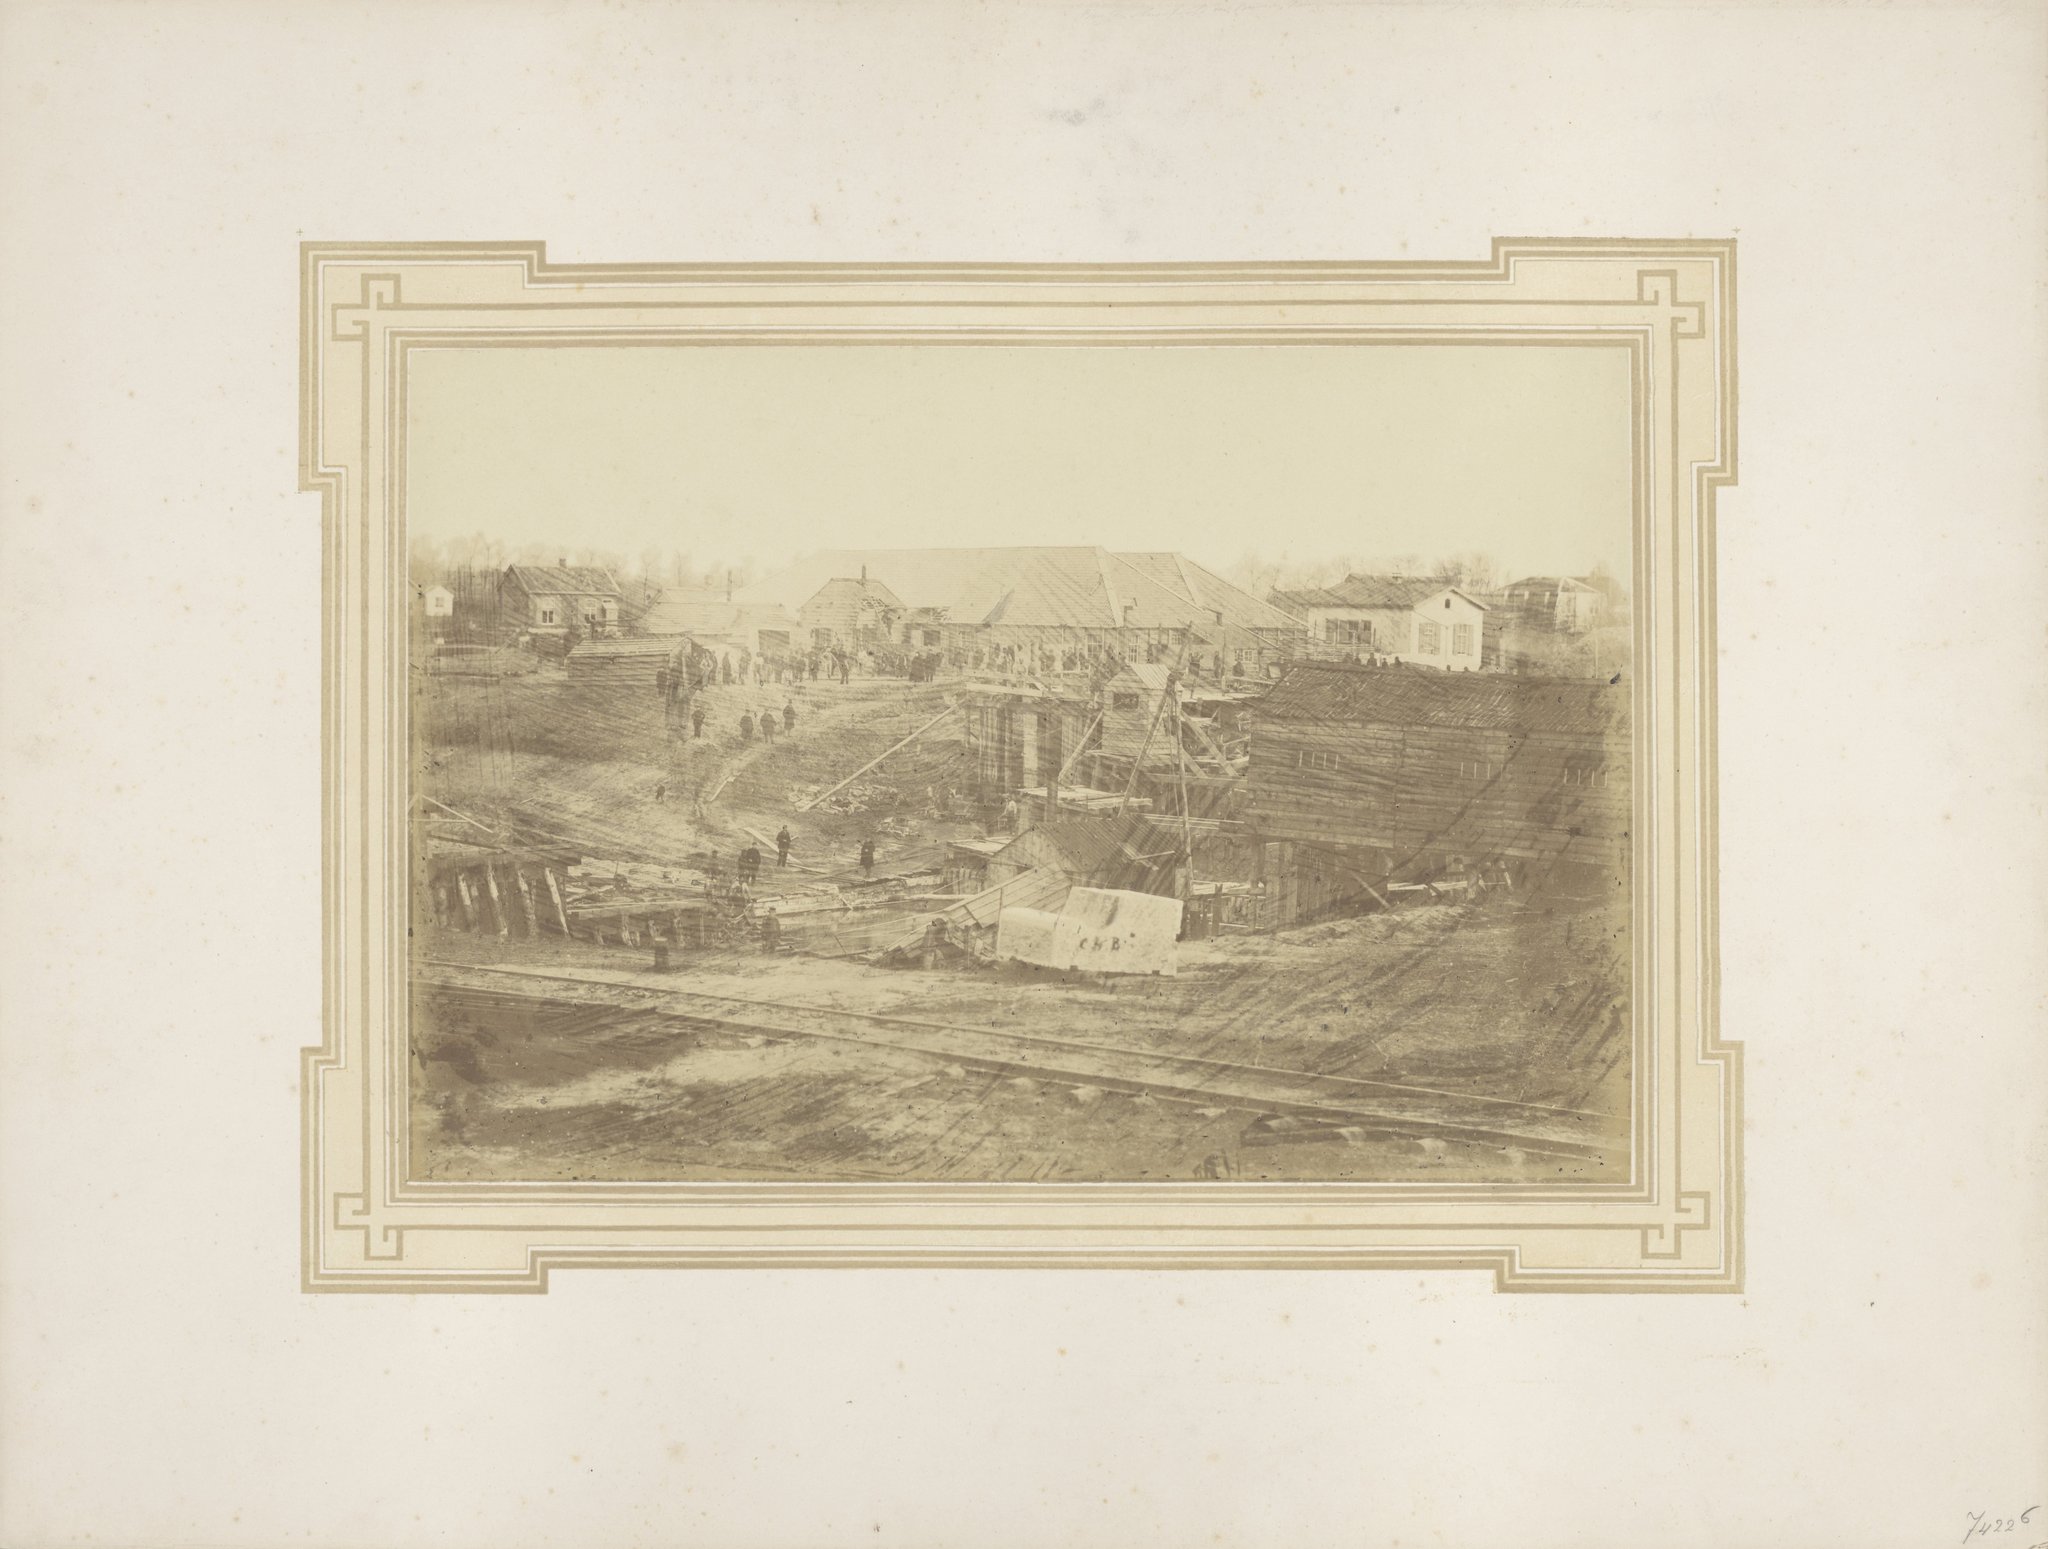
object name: photograph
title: Veertien platen betreffende de bouw van de sluis- en havenwerken te Vlissingen en het kanaal door Walcheren in juli 1869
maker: anton lauwrens preuninger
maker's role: fotograaf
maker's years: 1846-1919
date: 1807-1869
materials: cardboard, paper, photographic support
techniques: albumen print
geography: flushing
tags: sluice, weir, sea (seascape), building-site, flushing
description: Fundering van de binnenkeer- en schutsluis te Vlissingen, juli 1869. Onderdeel van een serie van veertien foto's van deze bouwprojecten in Zeeland.